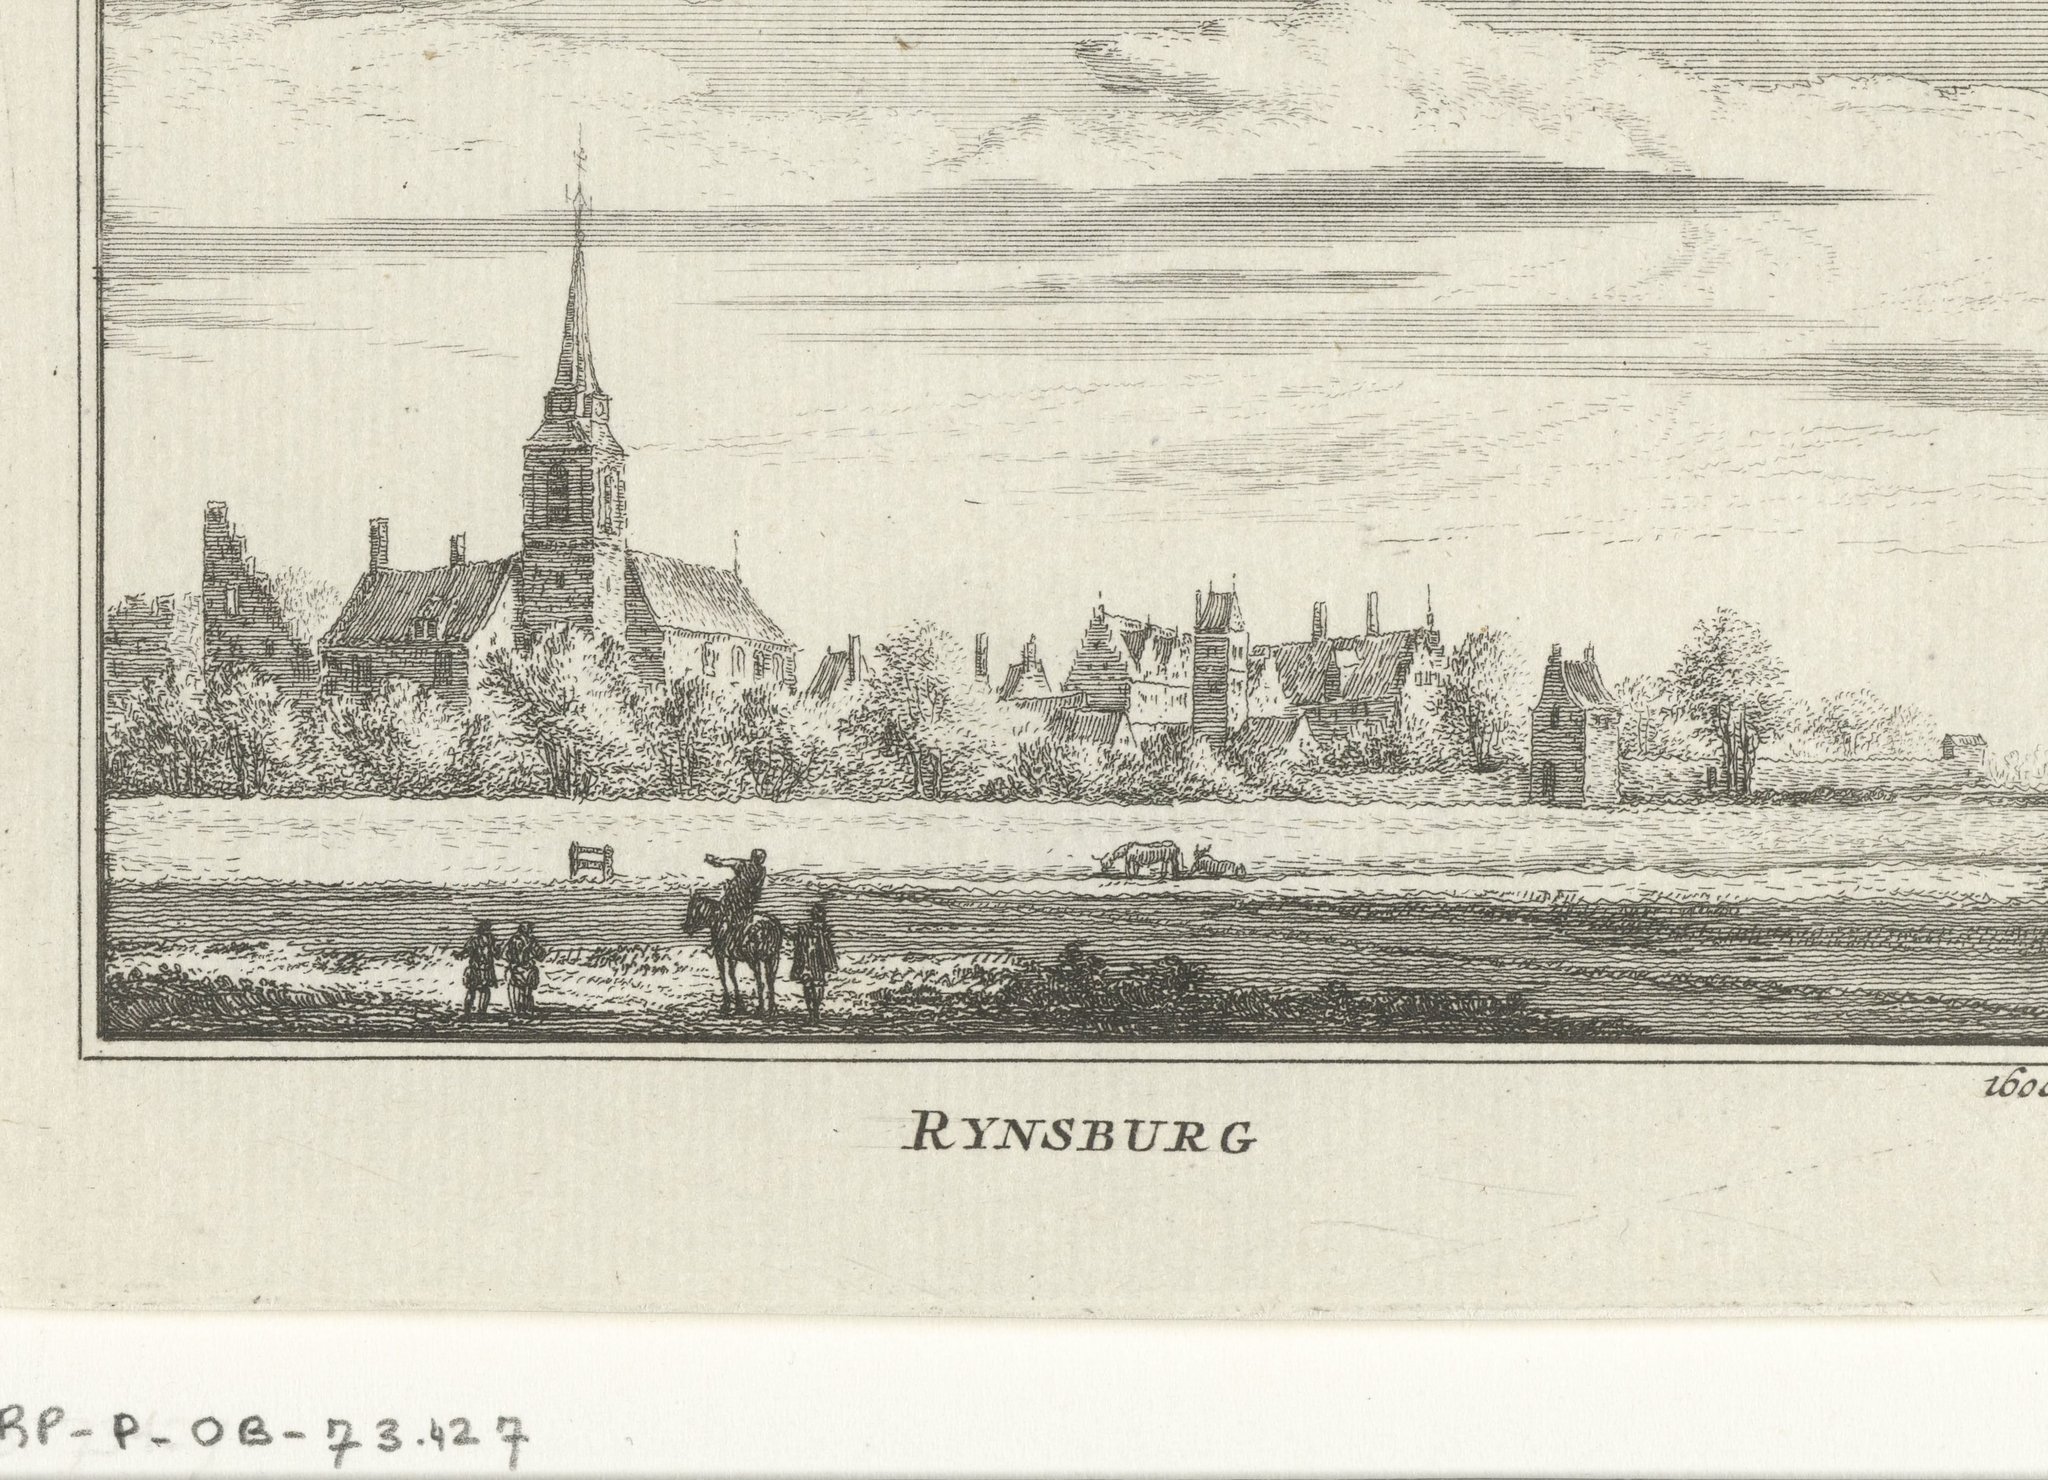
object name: print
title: Rynsburg 1600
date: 1727-1733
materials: paper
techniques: etching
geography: amsterdam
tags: prospect of village, silhouette of village, church (exterior)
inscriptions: collector's mark: Lugt 2228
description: Illustratie uit: Abraham Rademaker, Matthaeus Brouërius van Niedek, Isaac Le Long, Kabinet van Nederlandsche en Kleefsche outheden en (...) voorname stads- en landgebouwen, Willem Barents en Antoni Schoonenburg: Amsterdam, 1727-1733, ill. nr. 74.